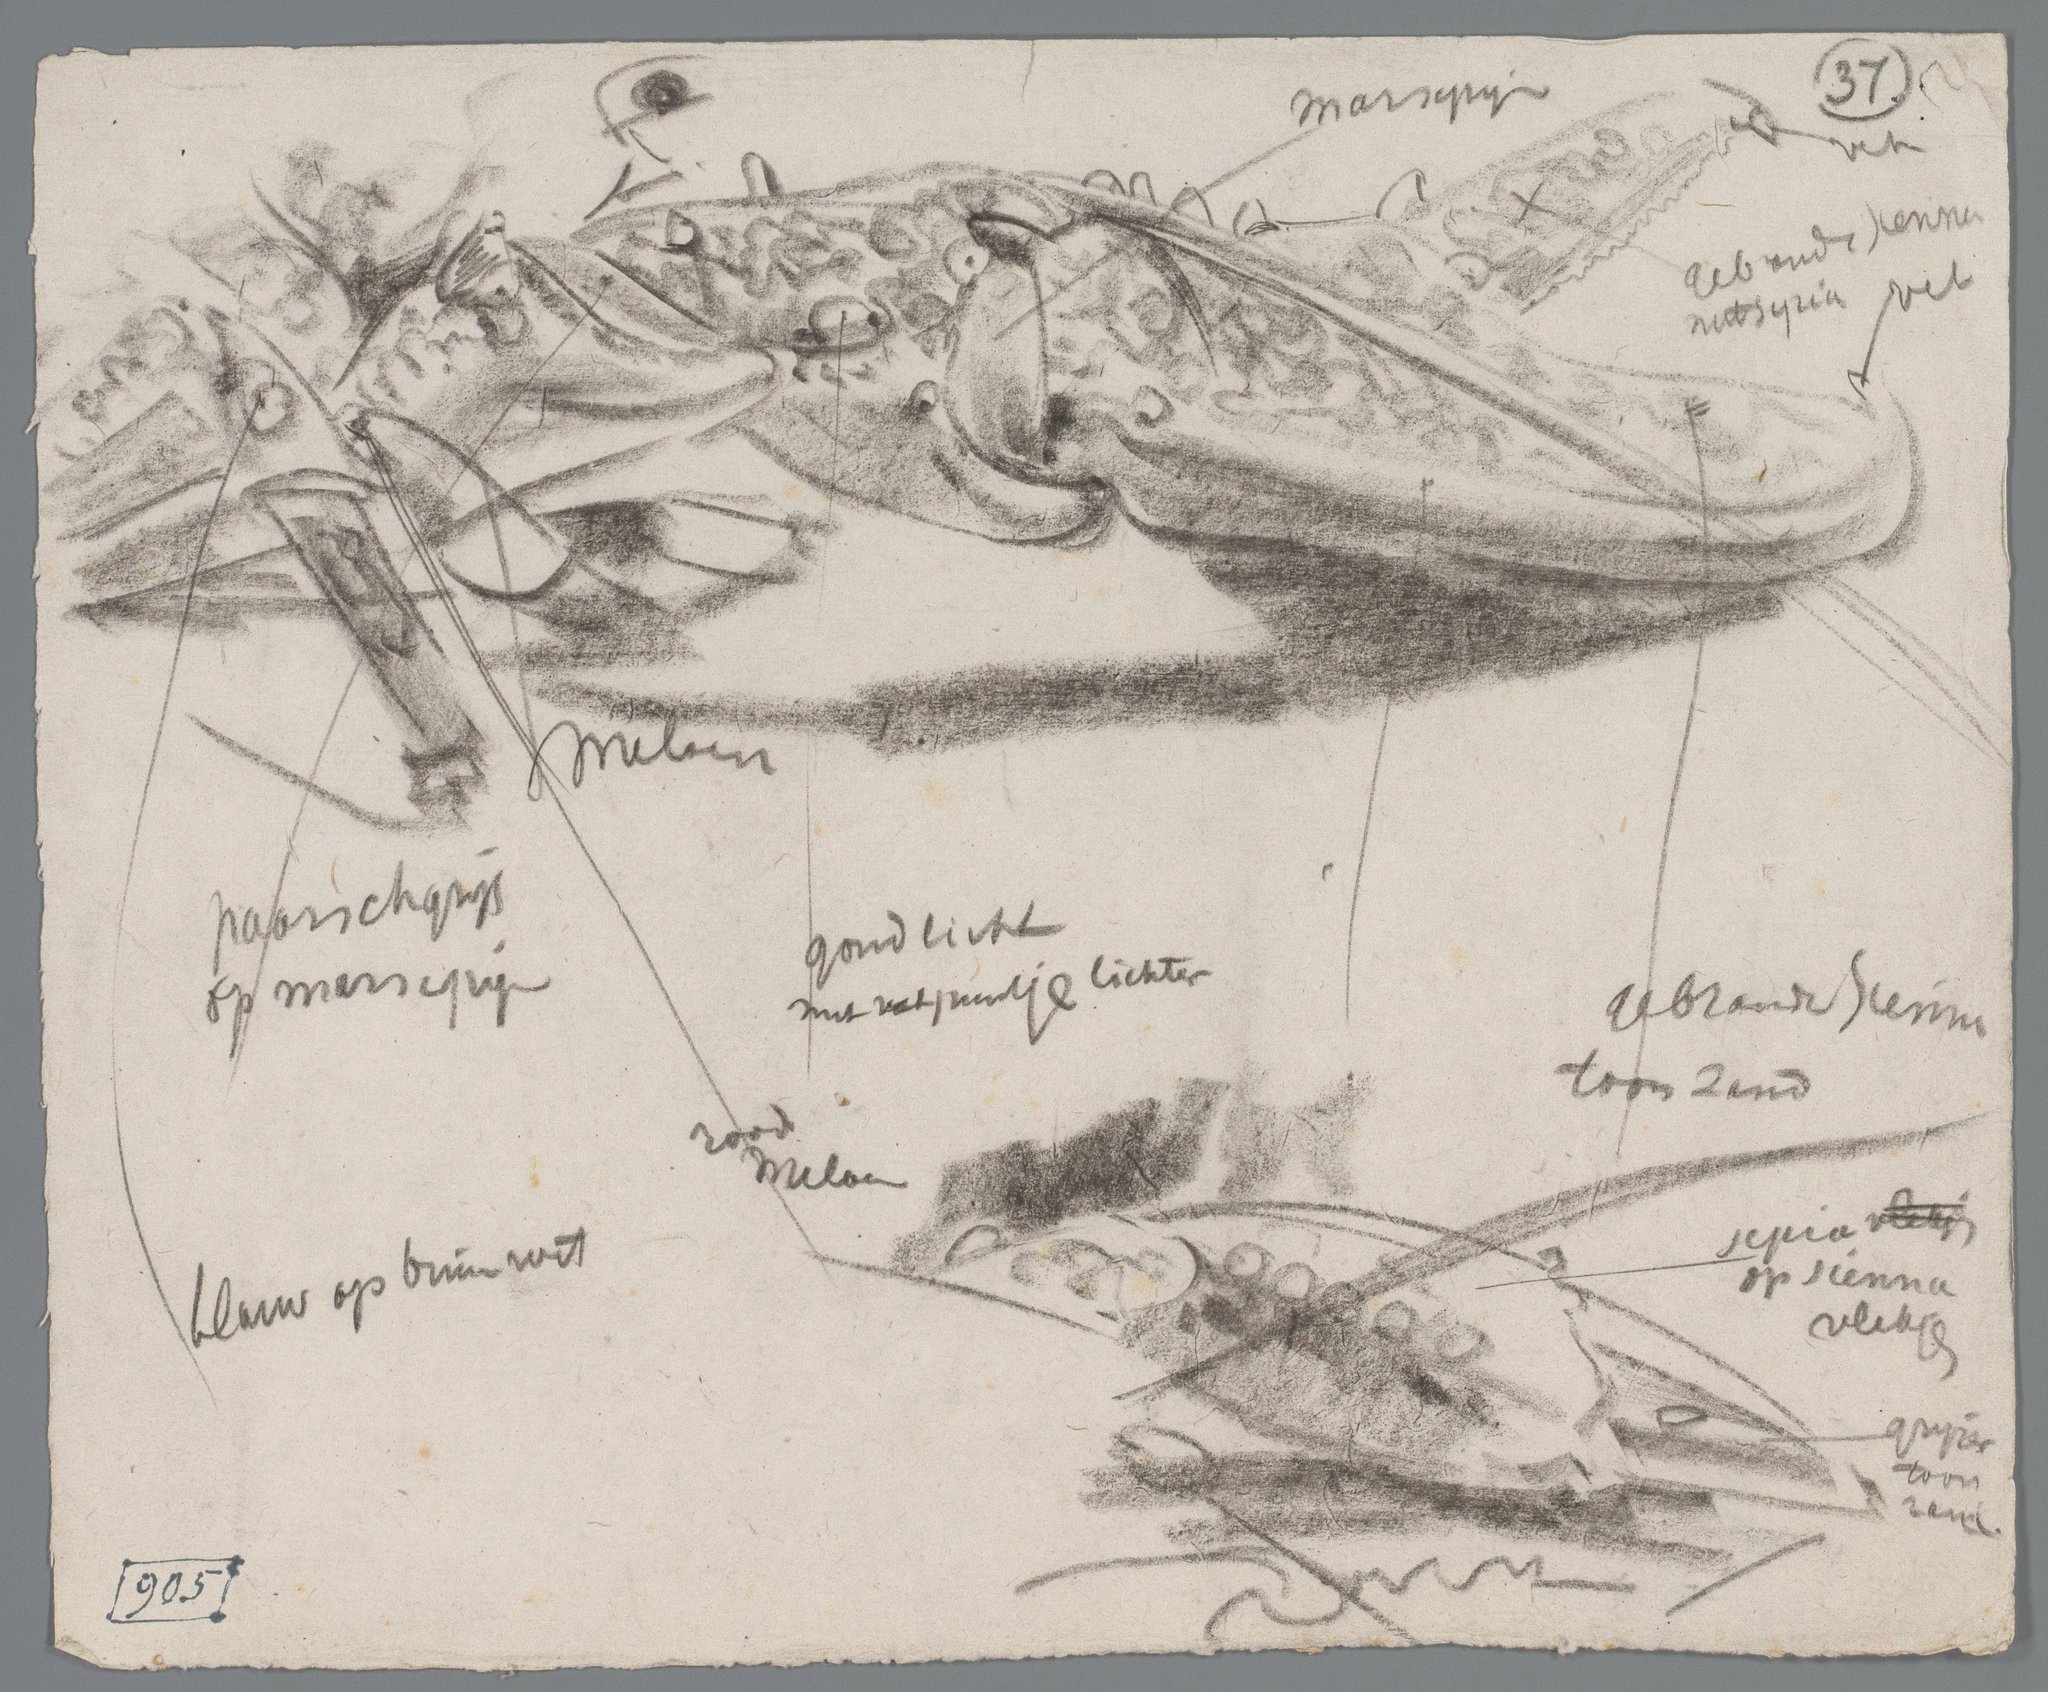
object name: drawing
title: Studies van kreeften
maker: gerrit willem dijsselhof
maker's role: designer, draughtsman, print maker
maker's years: 1866-1924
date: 1876-1924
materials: chalk, paper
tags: crustaceans: lobster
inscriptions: number: ‘37’, number: ‘905’